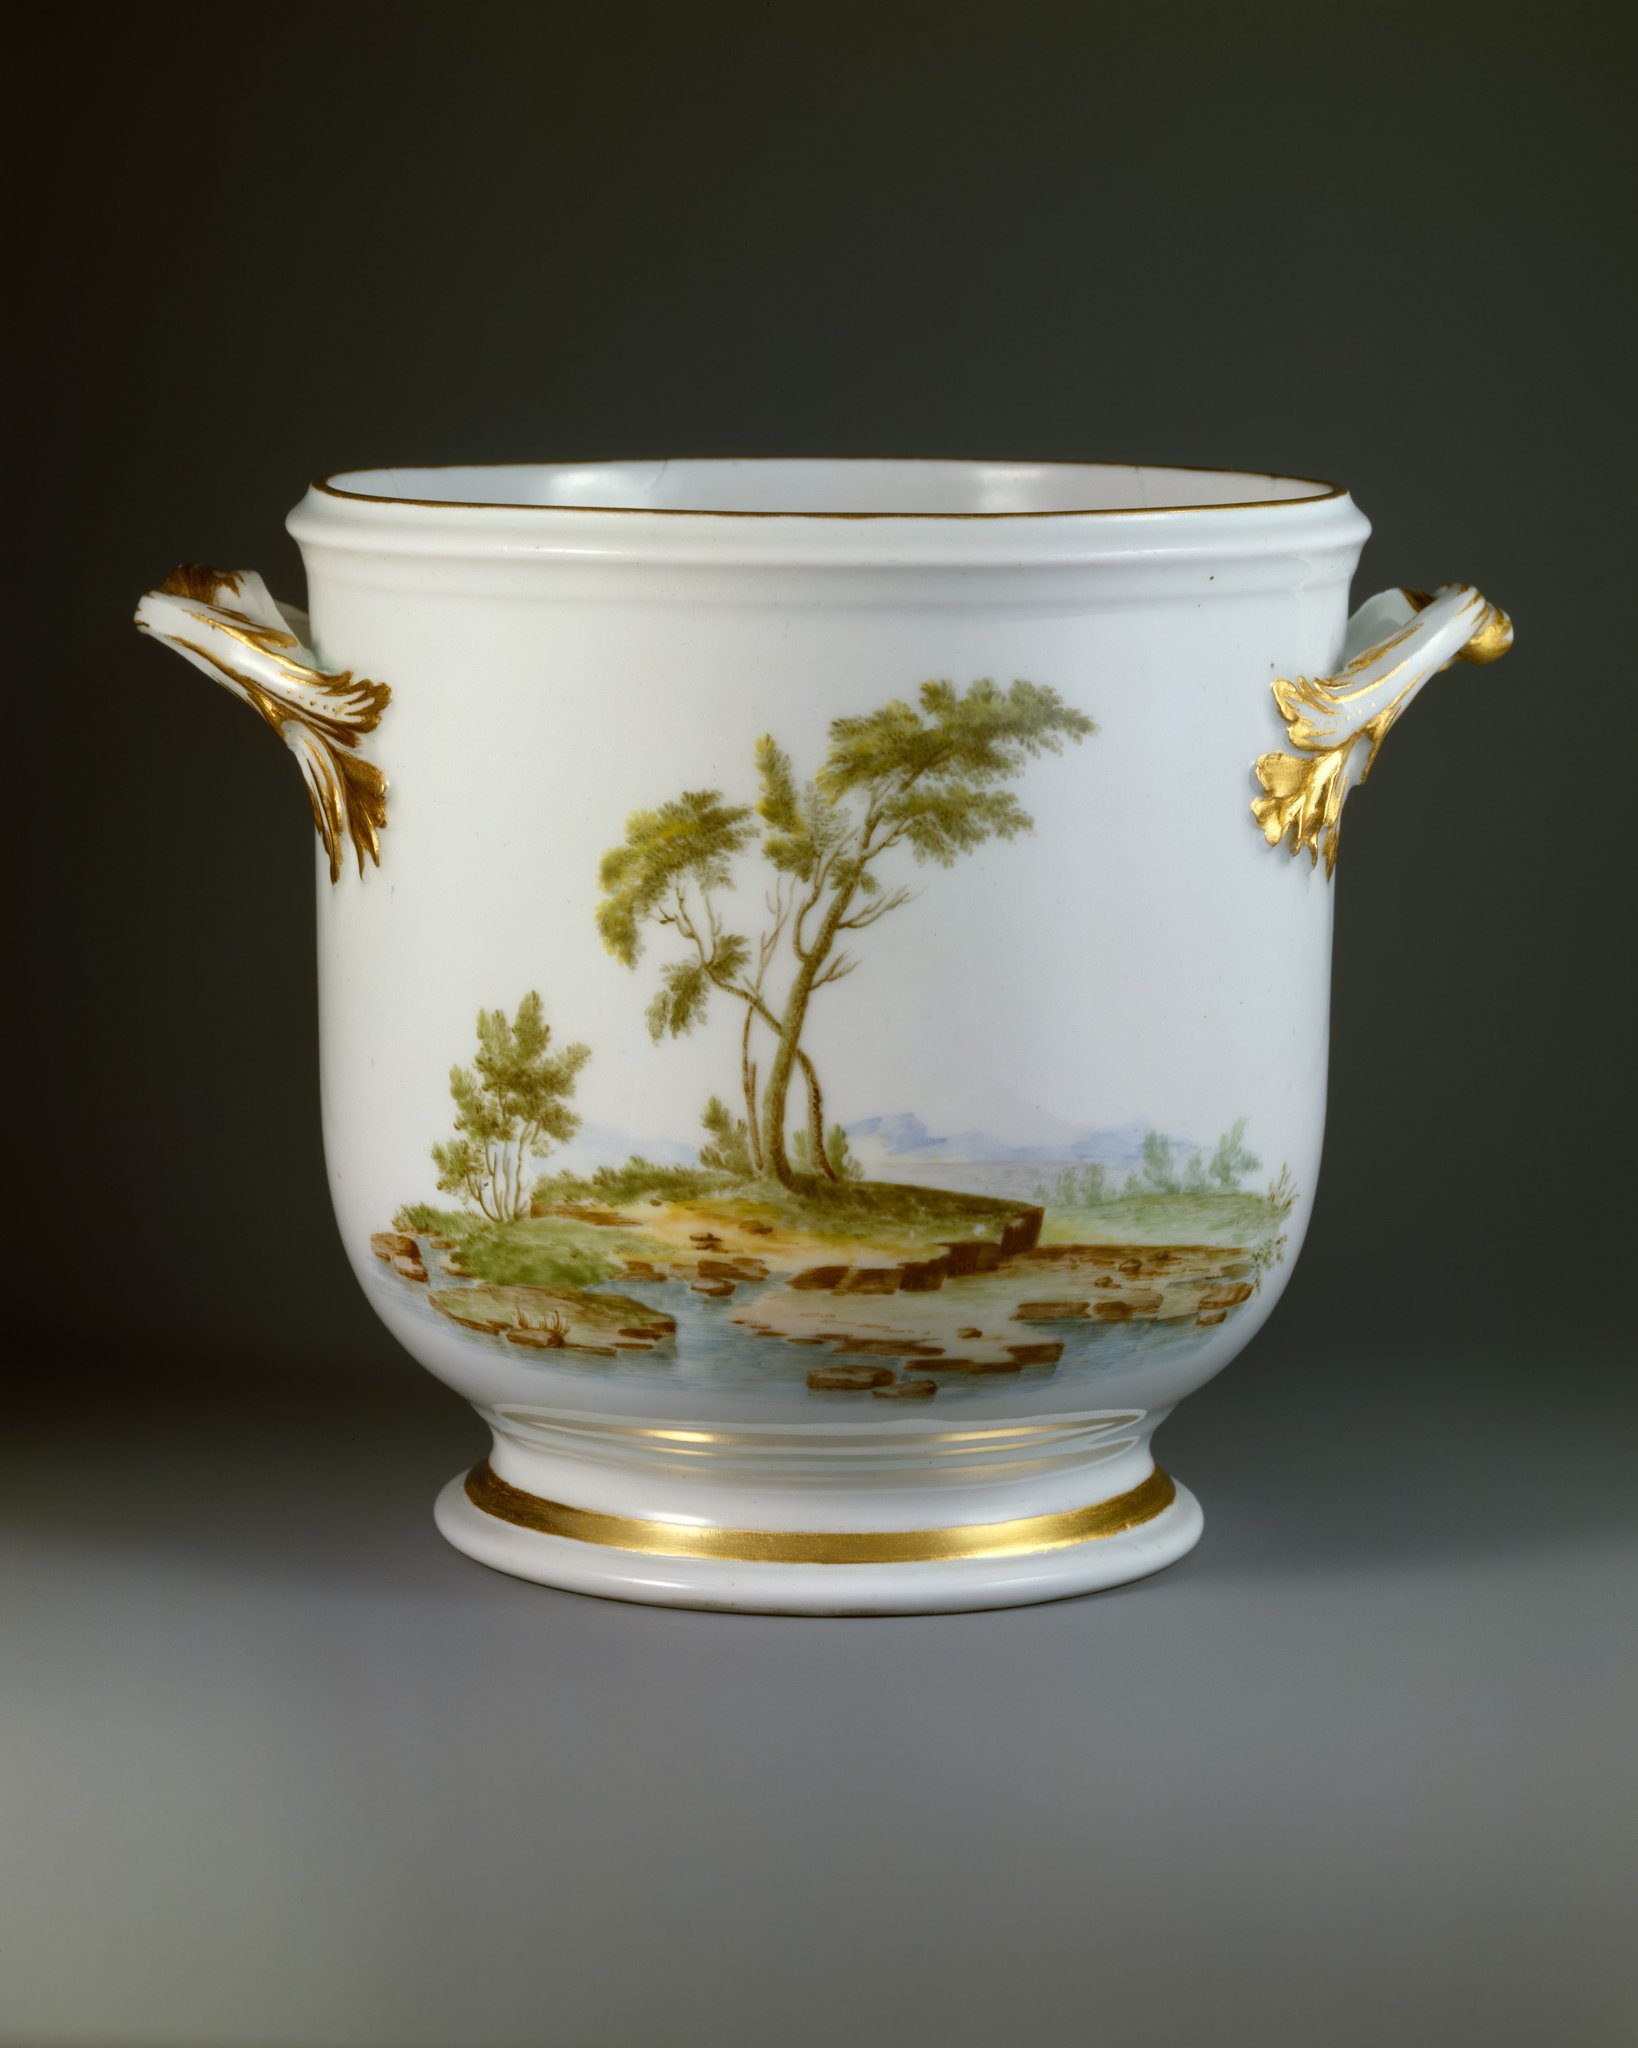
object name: wine cooler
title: Wine cooler (seau à demi-bouteille) (one of a pair)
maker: vincennes manufactory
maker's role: manufactory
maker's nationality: french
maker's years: 1740-1756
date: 1751-1752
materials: soft paste porcelain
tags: plants